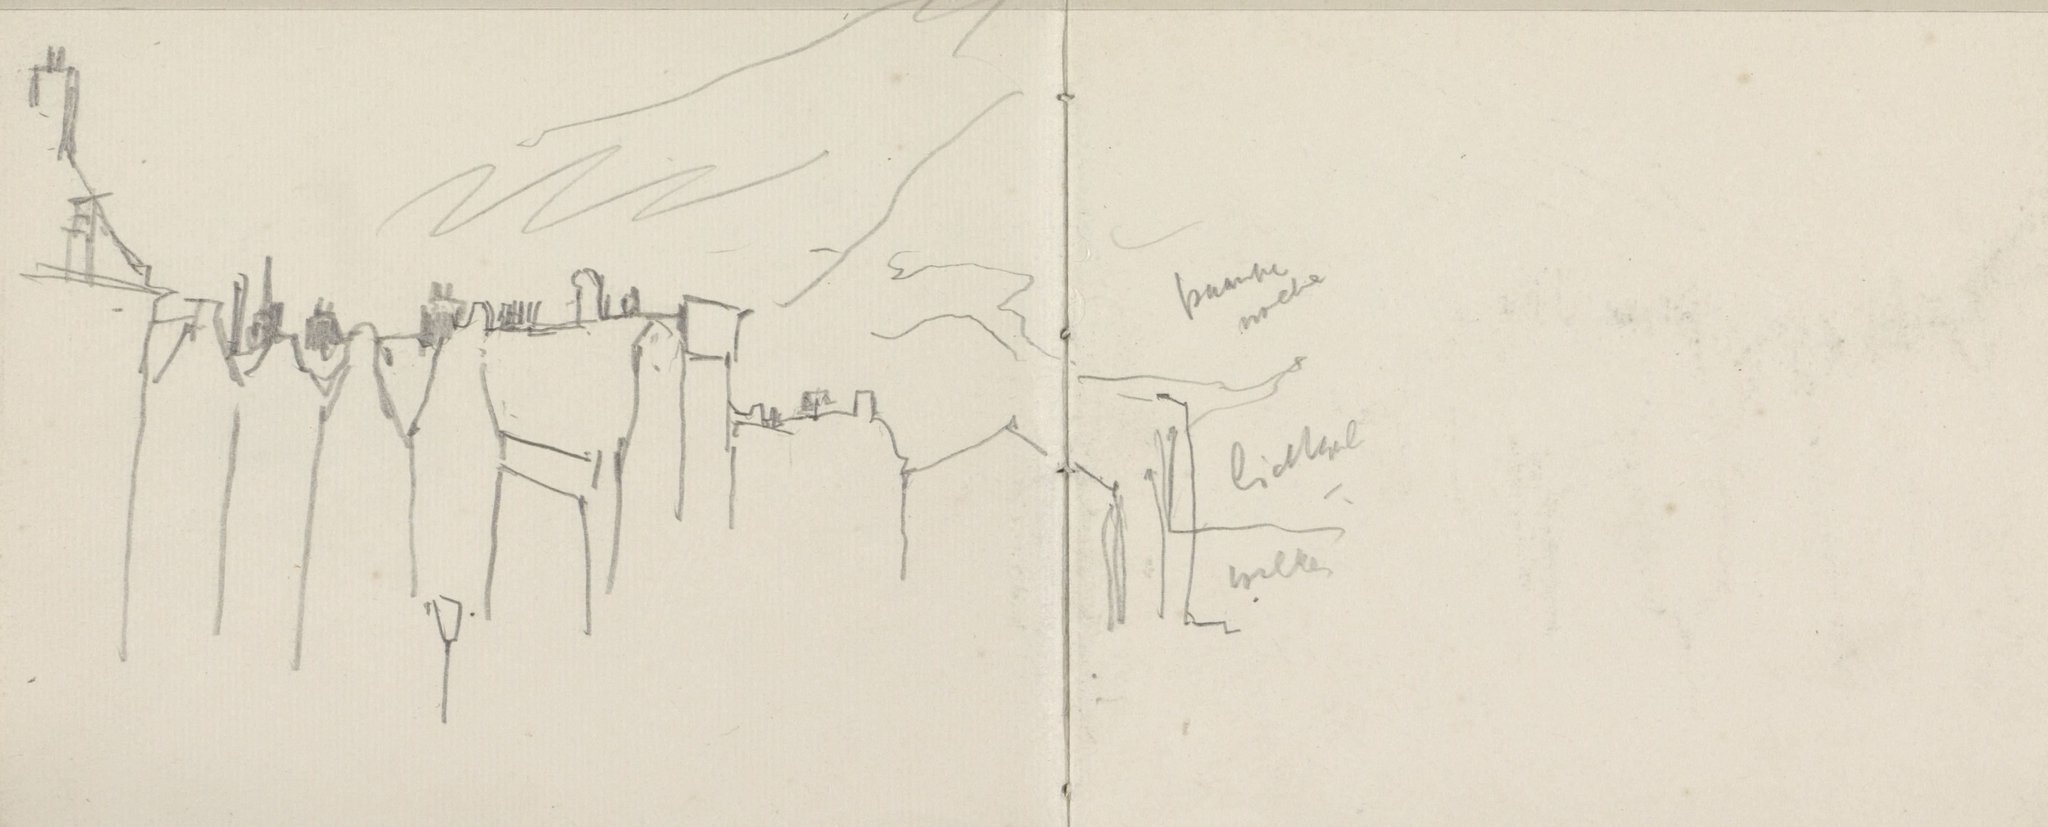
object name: sketchbook leaf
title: Looiersgracht te Amsterdam bij avond, gezien vanaf de Prinsengracht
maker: george hendrik breitner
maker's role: draughtsman, painter, print maker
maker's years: 1857-1923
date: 1886-1891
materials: paper, pencil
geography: amsterdam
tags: urban housing, canals, waters (in city)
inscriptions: kleurnotitie, handgeschreven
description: Pagina 51 en pagina 52 uit een schetsboek met 32 bladen.